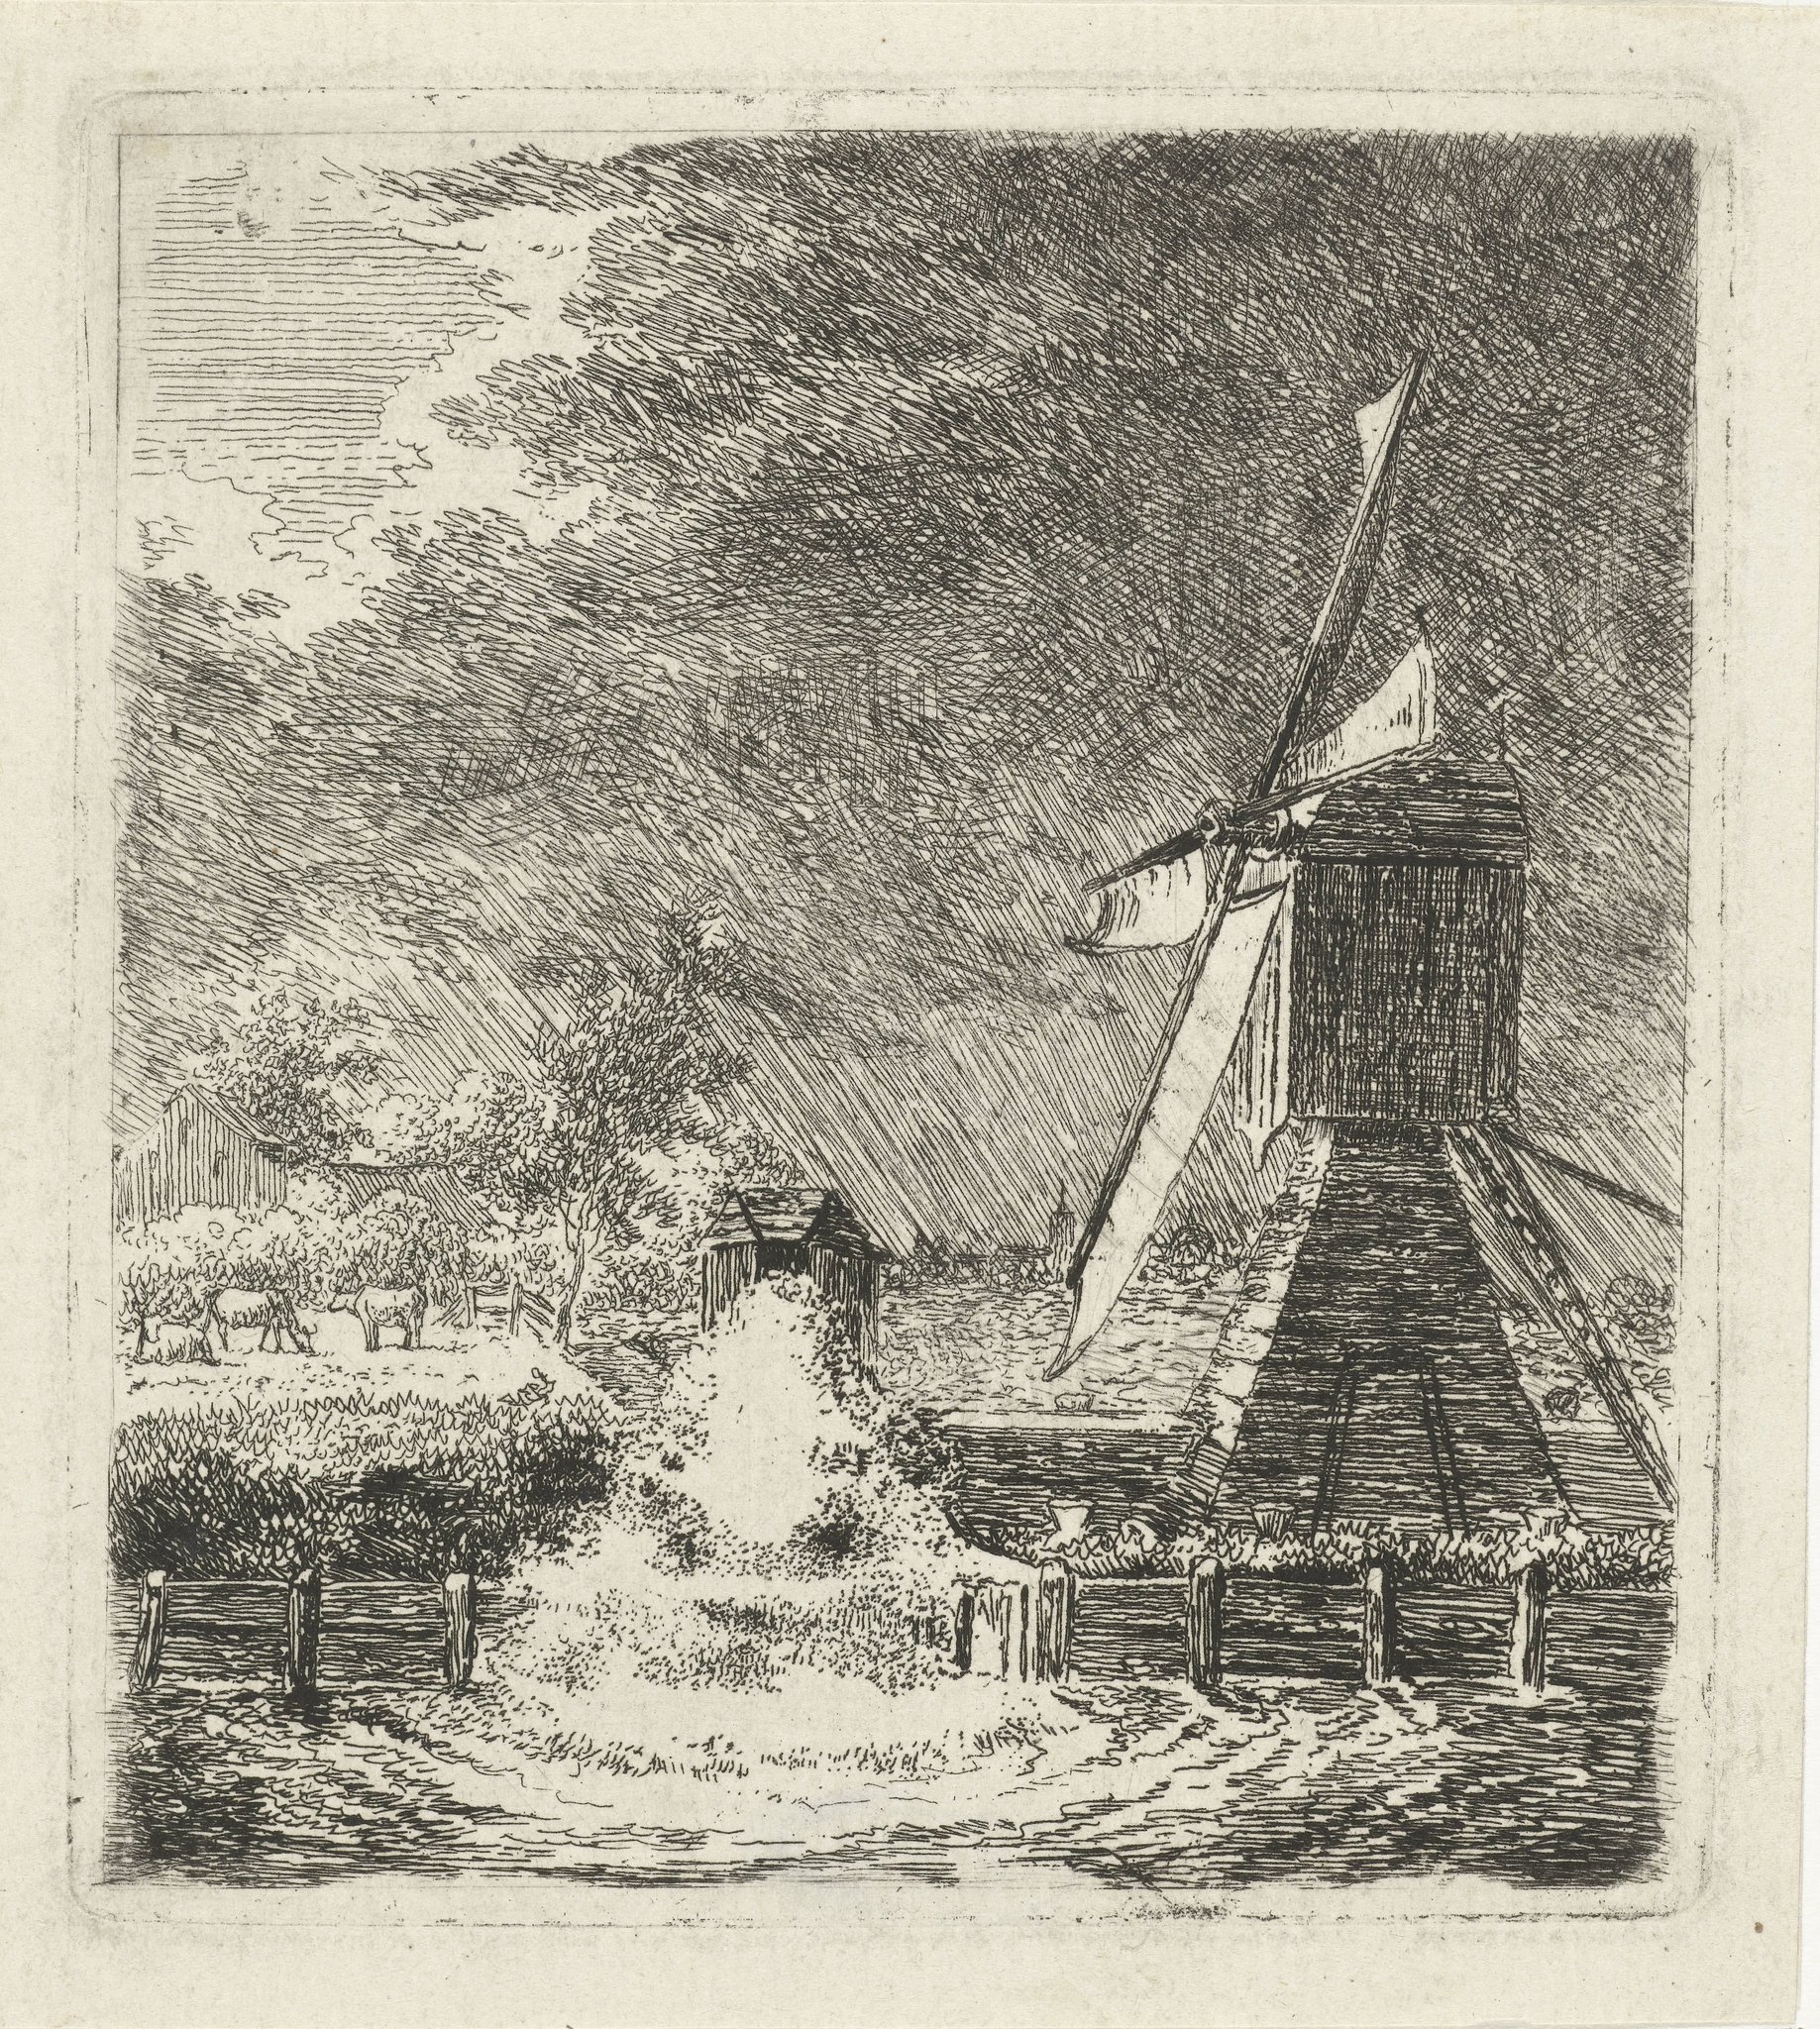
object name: print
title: Molen in een polderlandschap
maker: louis bernard coclers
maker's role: draughtsman, print maker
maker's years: 1741-1817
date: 1756-1817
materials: paper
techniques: etching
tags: windmill in landscape, polder, reclaimed land